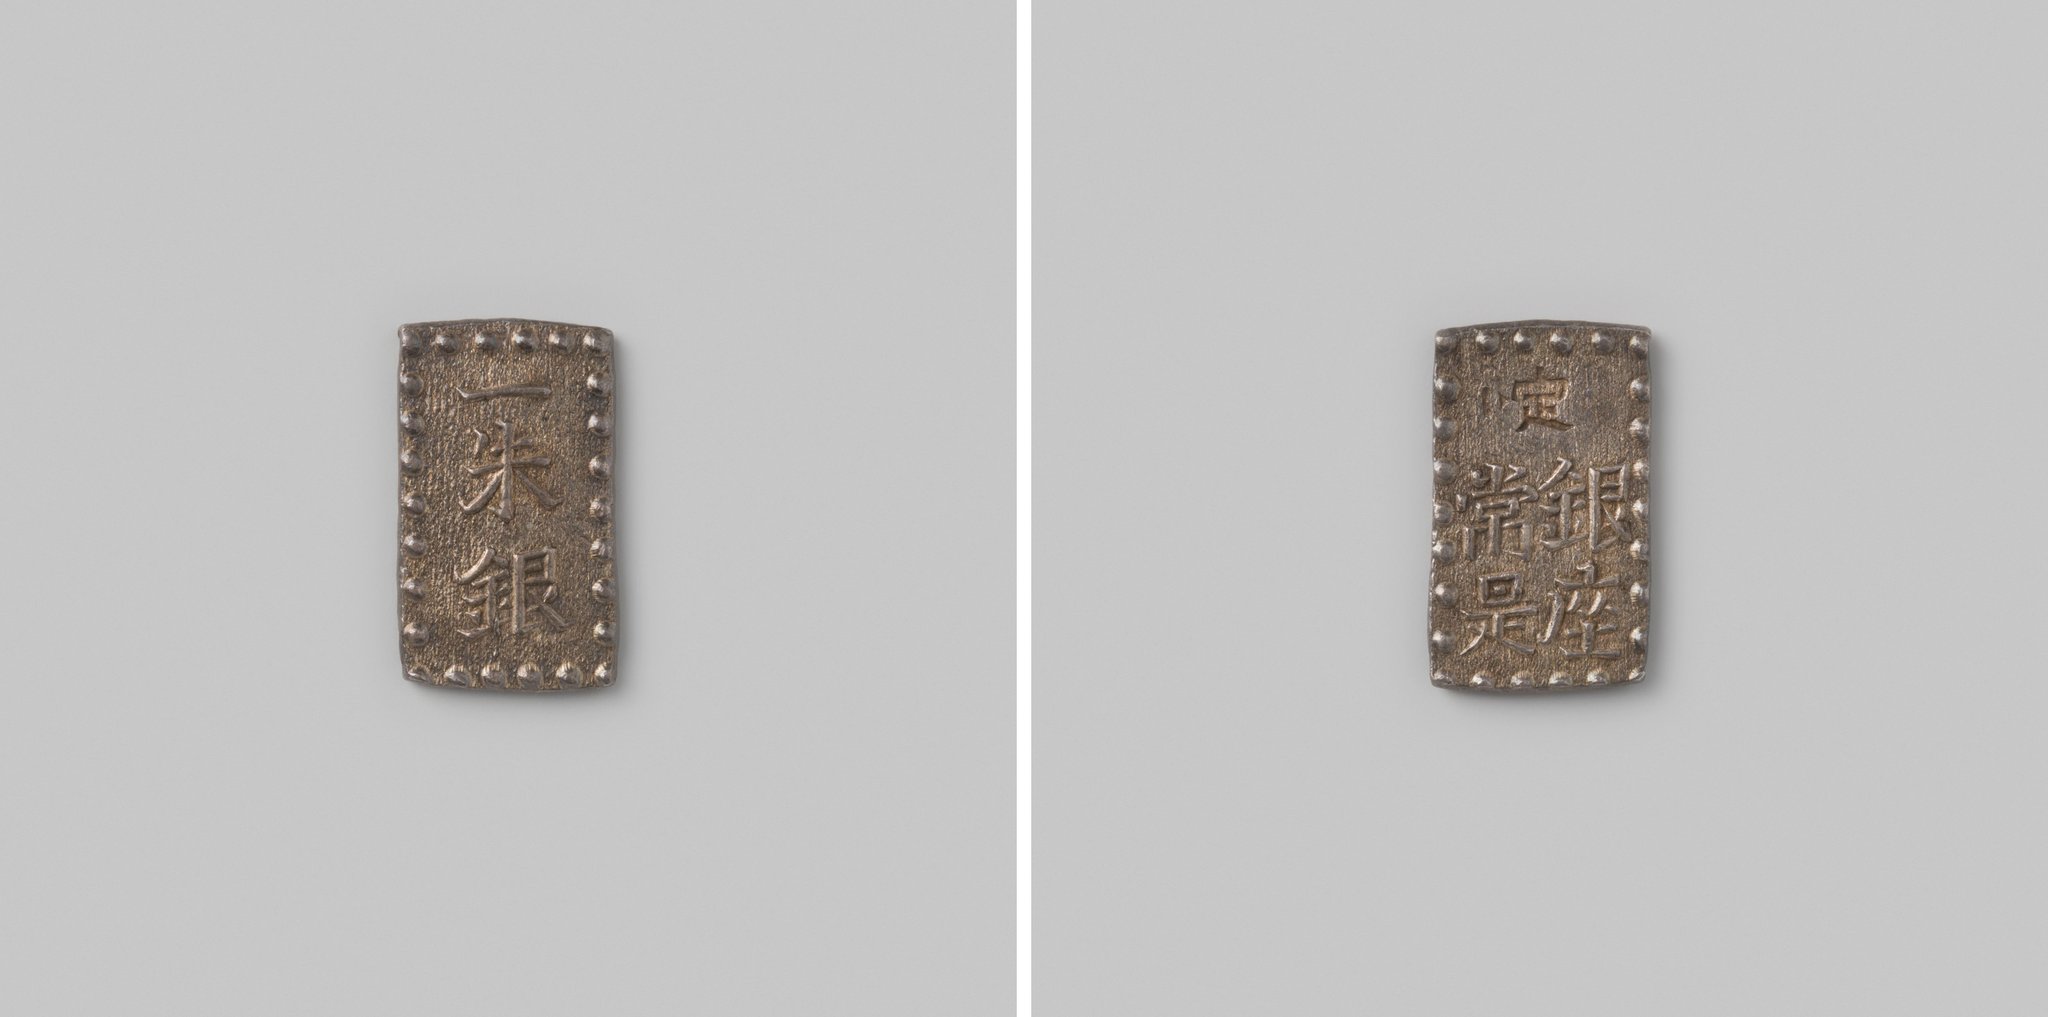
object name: coin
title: Isshu gin = zilveren 1 shu van het keizerrijk Japan, uit het Kaie tijdperk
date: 1846-1853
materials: silver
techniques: striking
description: Zilveren munt. Voorzijde: twee naar elkaar toegewende bloem-motieven, waartussen waarde-aanduiding: 1, aangegeven door een liggende streep rechts en links het letterteken voor bu. Keerzijde: binnen rechthoek onder elkaar geplaatste tekens met rechtsboven het teken voor het tenpo tijdperk.